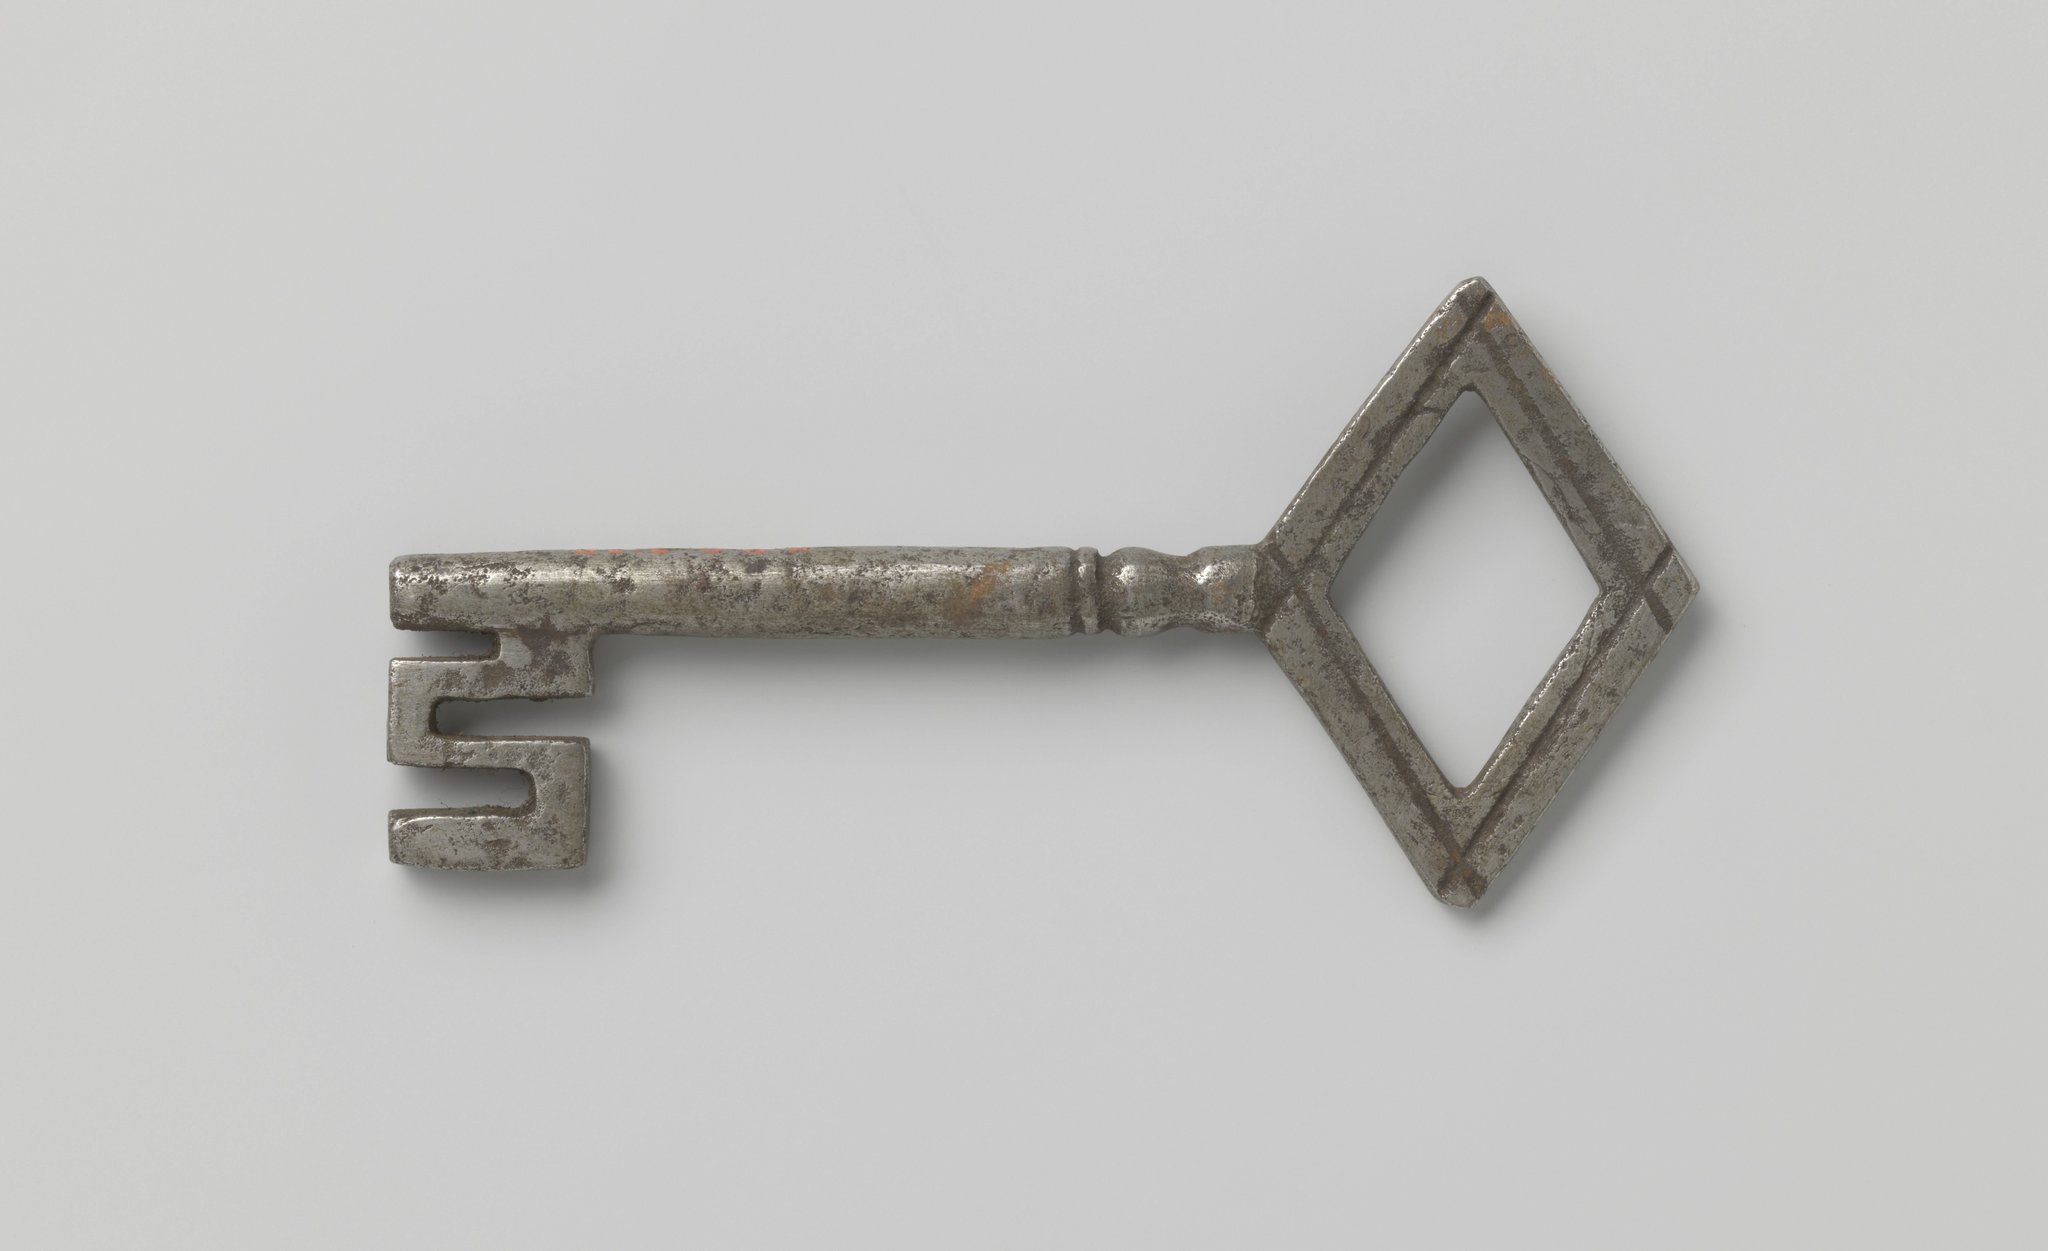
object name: key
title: Sleutel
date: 1600-1699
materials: iron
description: Sleutel met ruitvormig oog. Deze is door lijnen gegroefd; die elkaar op de hoeken snijden.